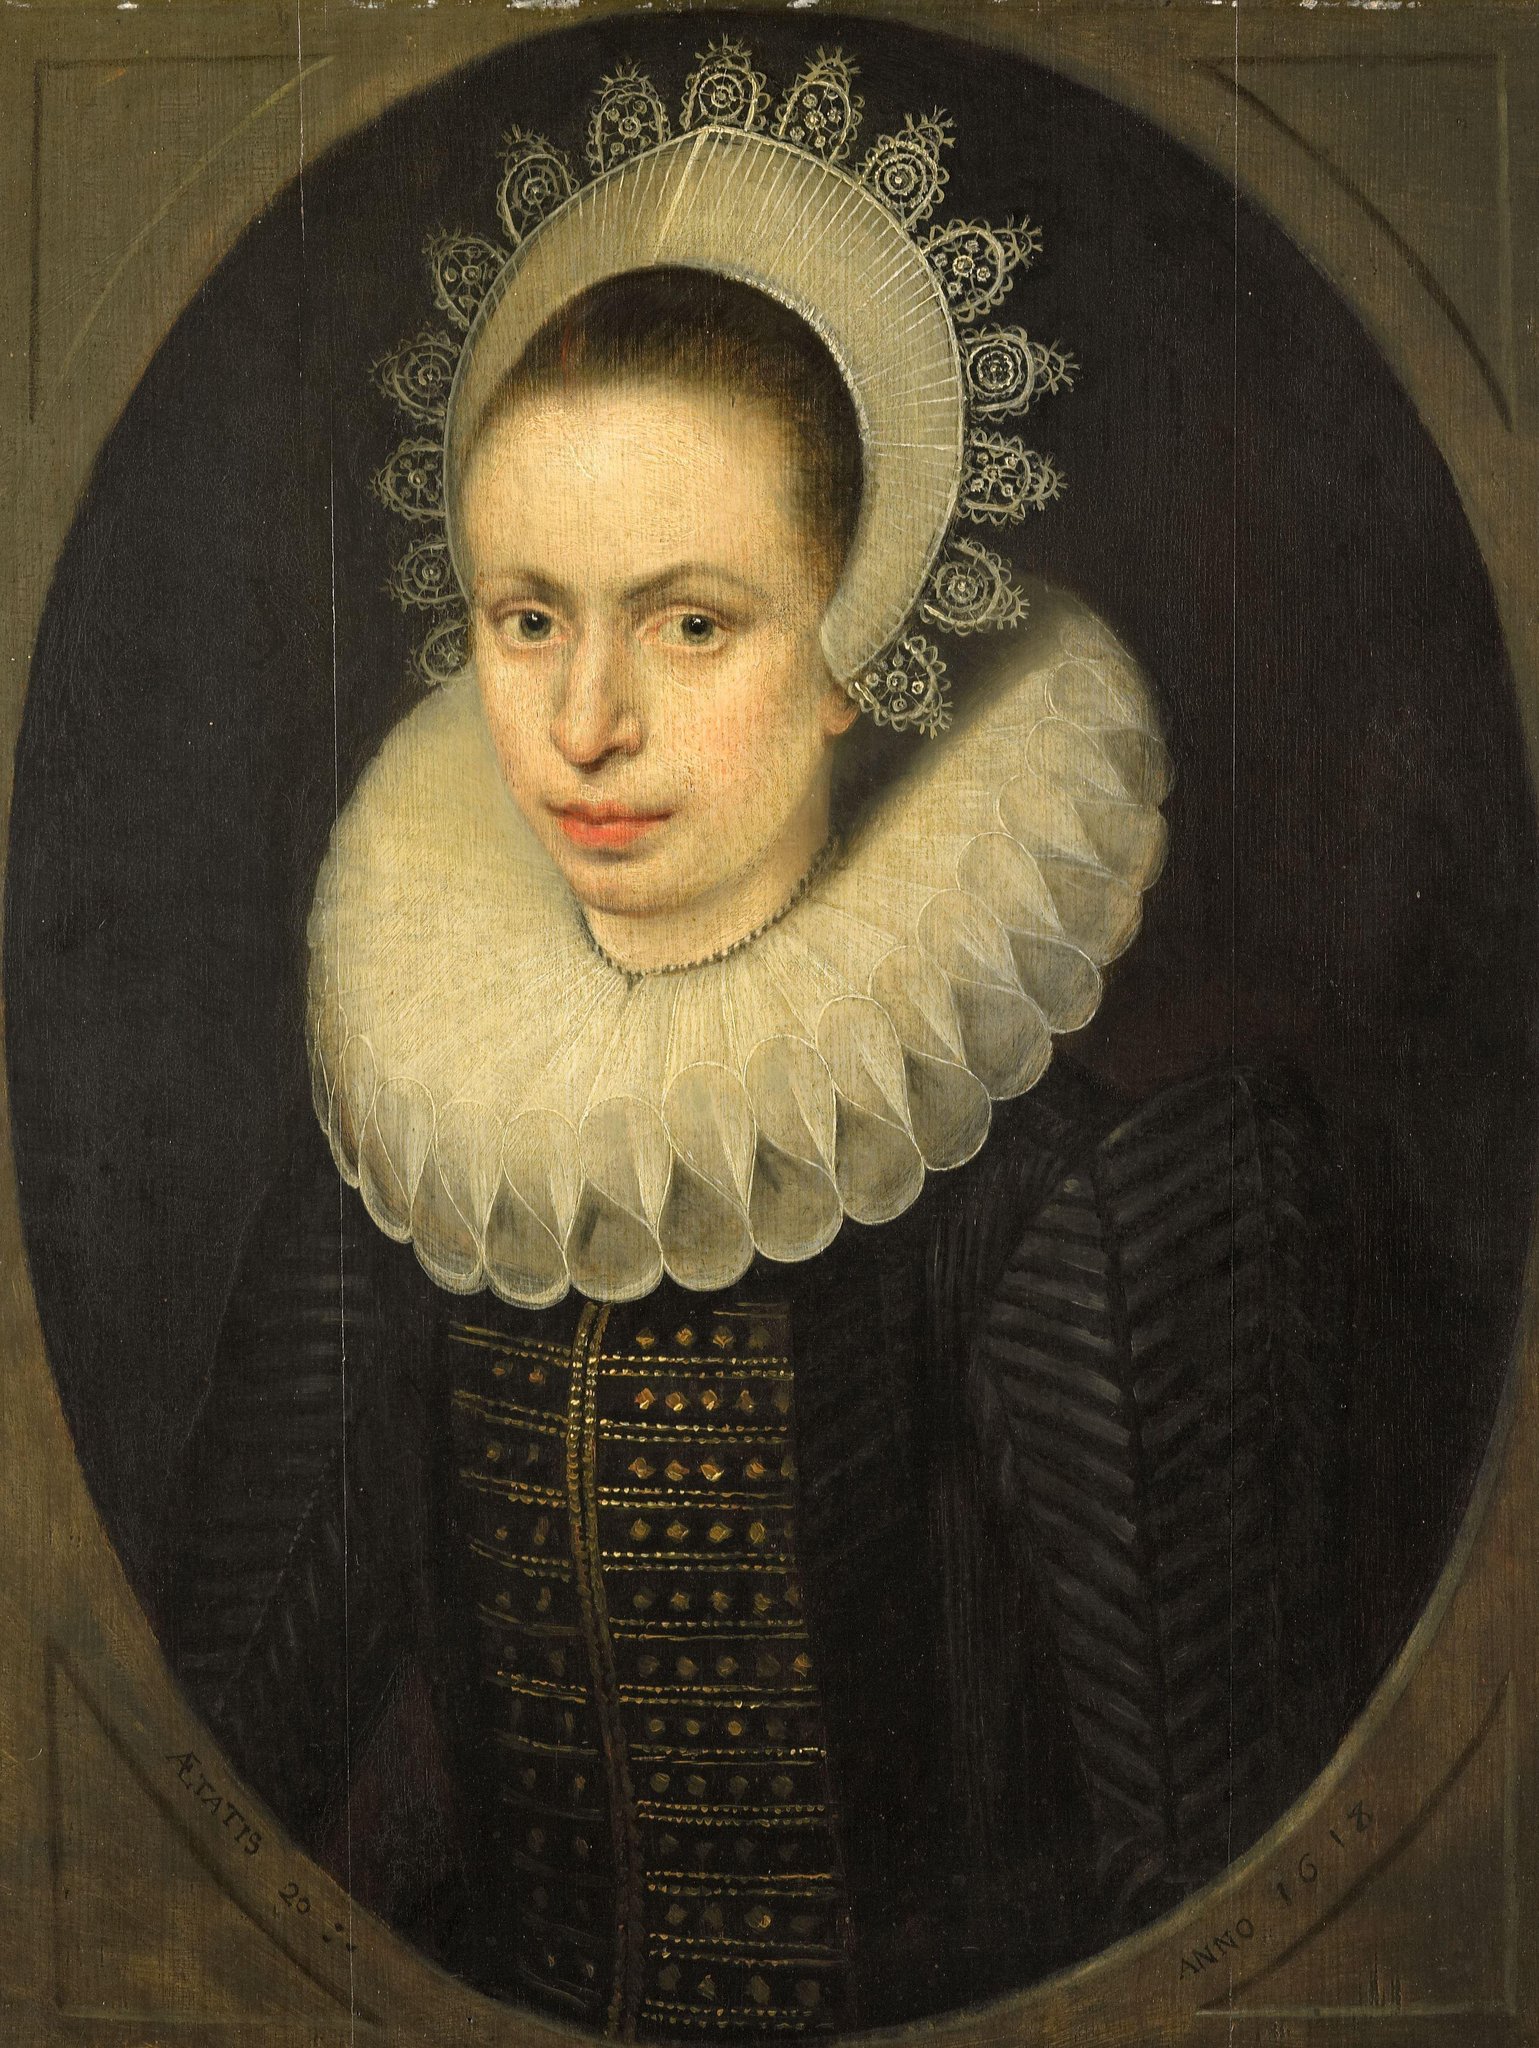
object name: painting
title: Portrait of Antoinette Walleran (1598-?)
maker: jacob lambrechtsz loncke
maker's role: painter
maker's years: 1580-1644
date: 1618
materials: oil, panel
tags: historical persons - bb - woman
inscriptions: inscription, lower left: ‘ÆTATIS 20’, date, lower right: ‘ANNO 1618’, inscription, on the reverse: ‘Antoinette Walleran. / Echtgen: van Ph: Le Mire / Geb: / Overl: / 23’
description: Portret van Antoinette Walleran, de echtgenote van Phillipe le Mire. Buste, in ovaal, naar rechts. Pendant van SK-A-906.